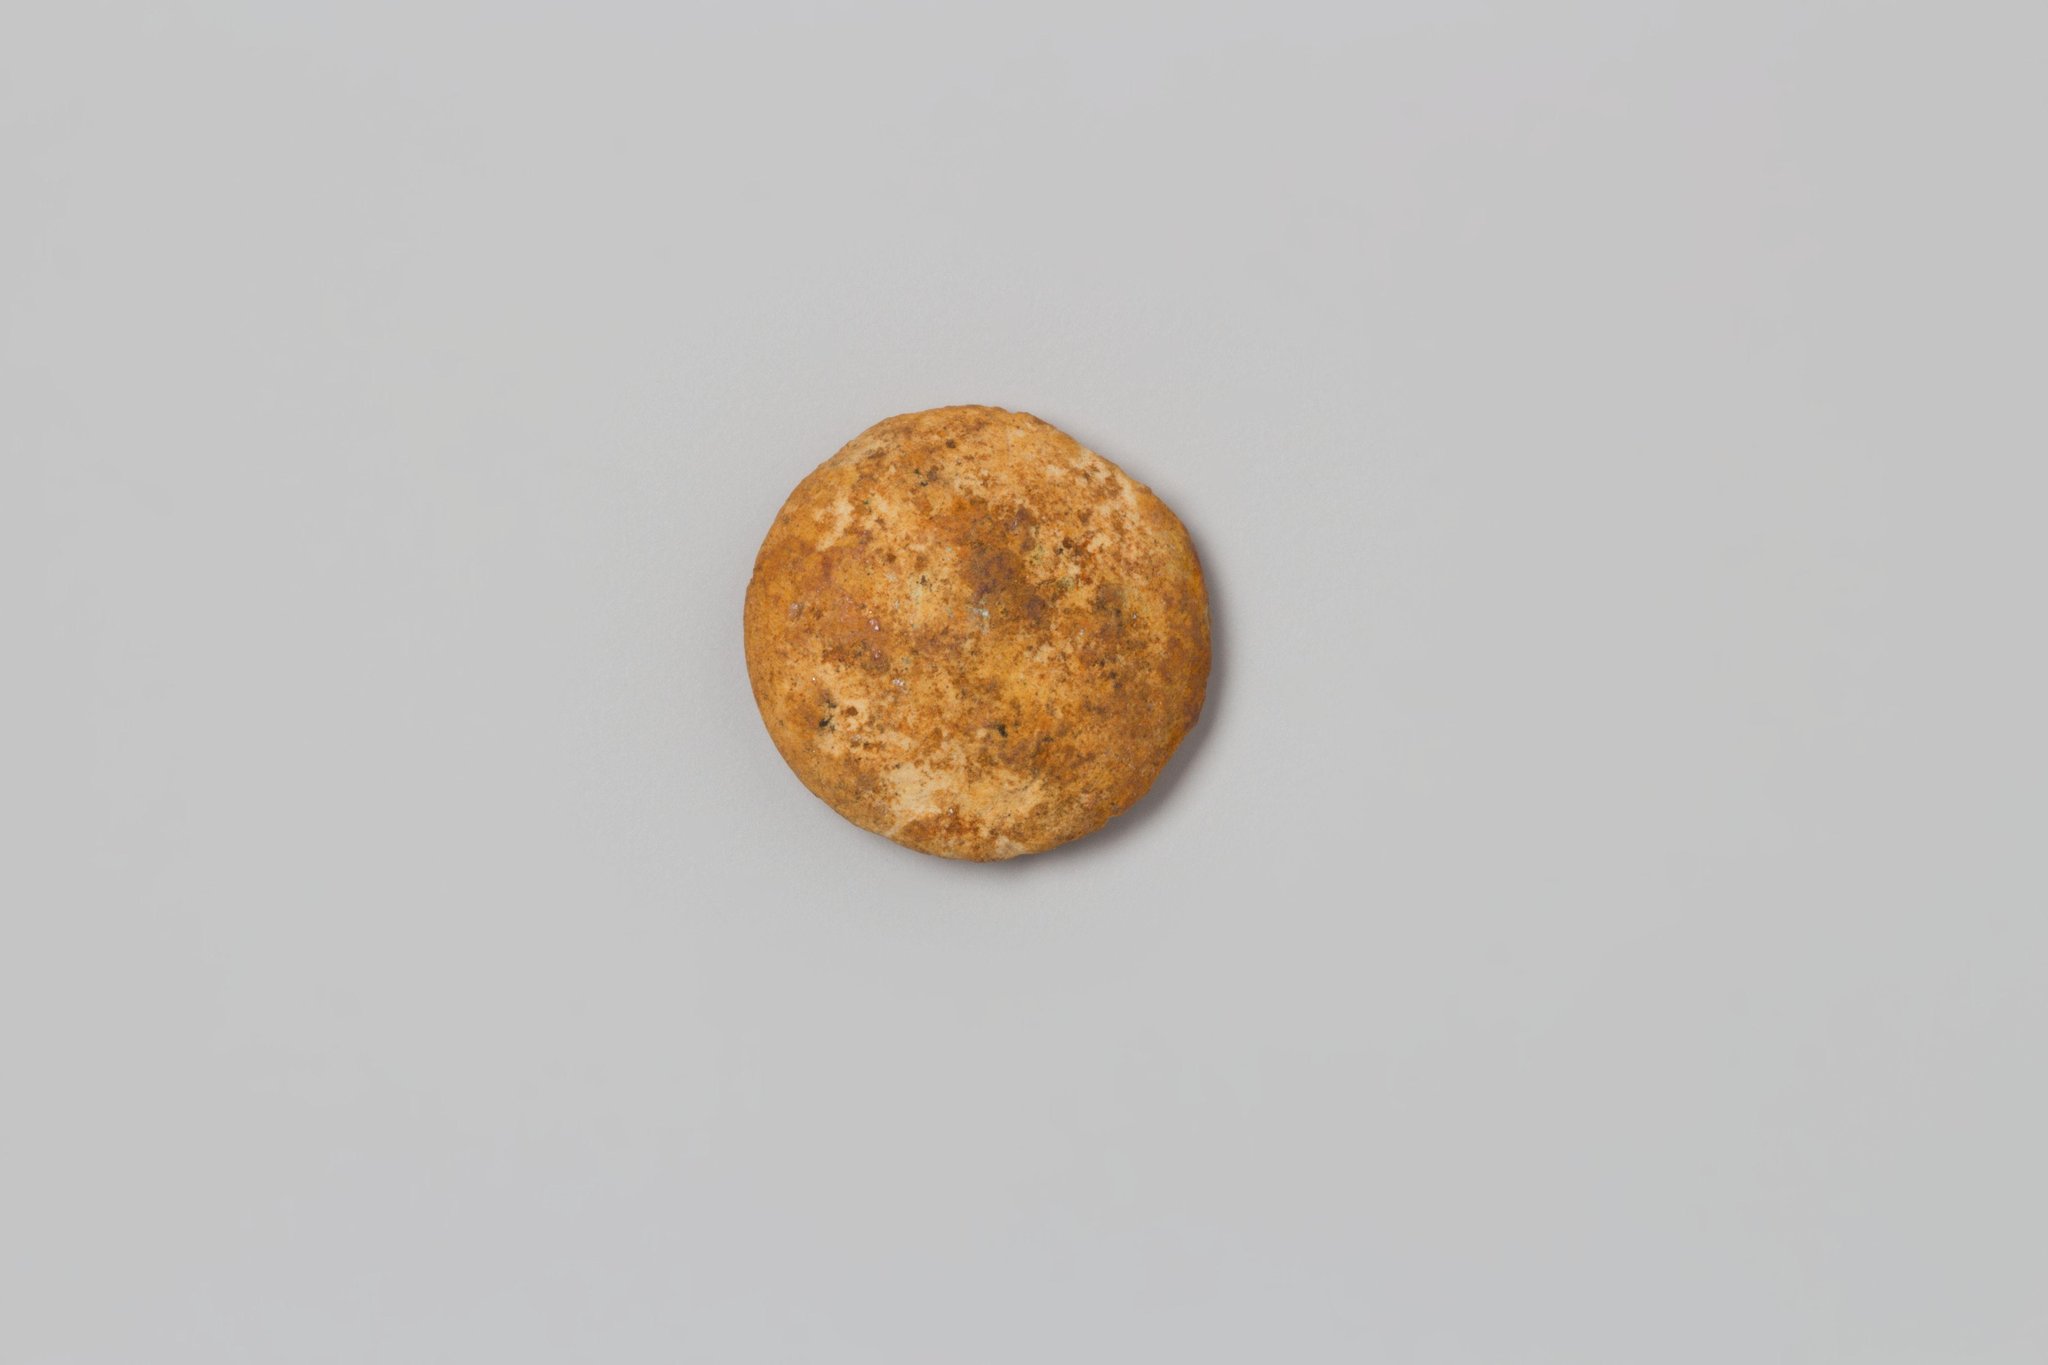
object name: button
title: Knoop uit het wrak van de Oost-Indiëvaarder Hollandia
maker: Anonymous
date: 1700-1743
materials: bone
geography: netherlands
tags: verenigde oostindische compagnie, hollandia (schip), annet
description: Fragm id. NG 1980-27H1137, shank broken.